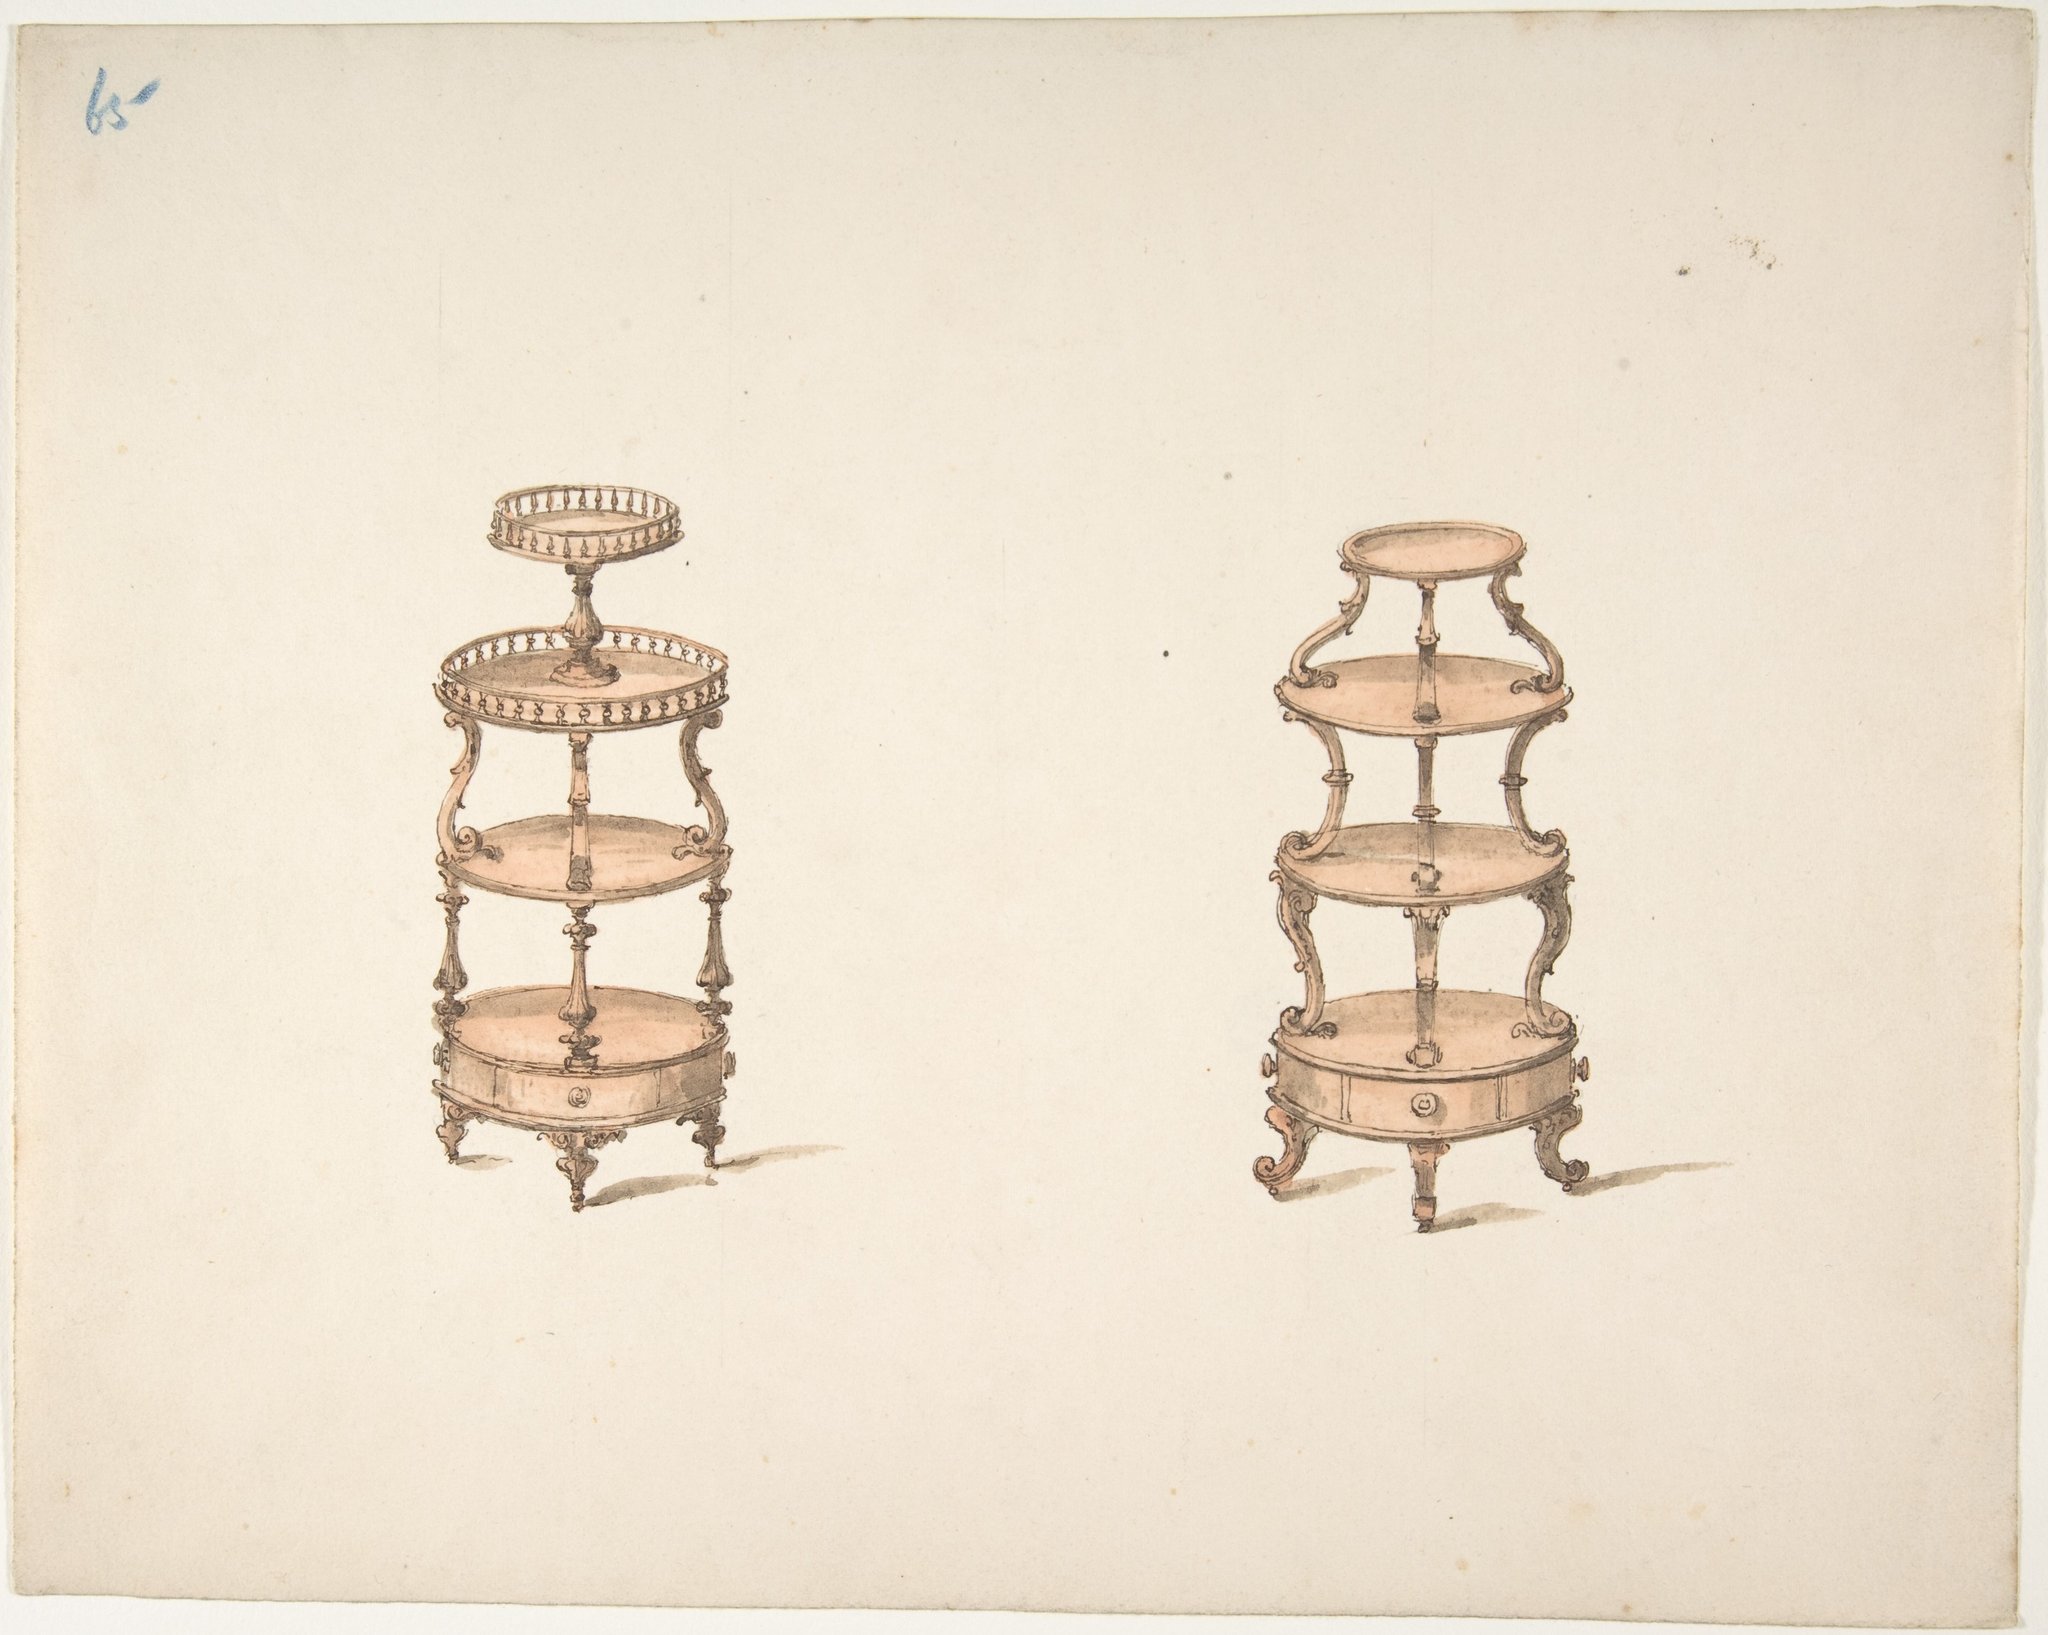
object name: drawing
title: Two Whatnots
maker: anonymous, british, 19th century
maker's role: artist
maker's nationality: british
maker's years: 1800-1900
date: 1801-1833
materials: ink, watercolor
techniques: brush, pen, wash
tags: furniture